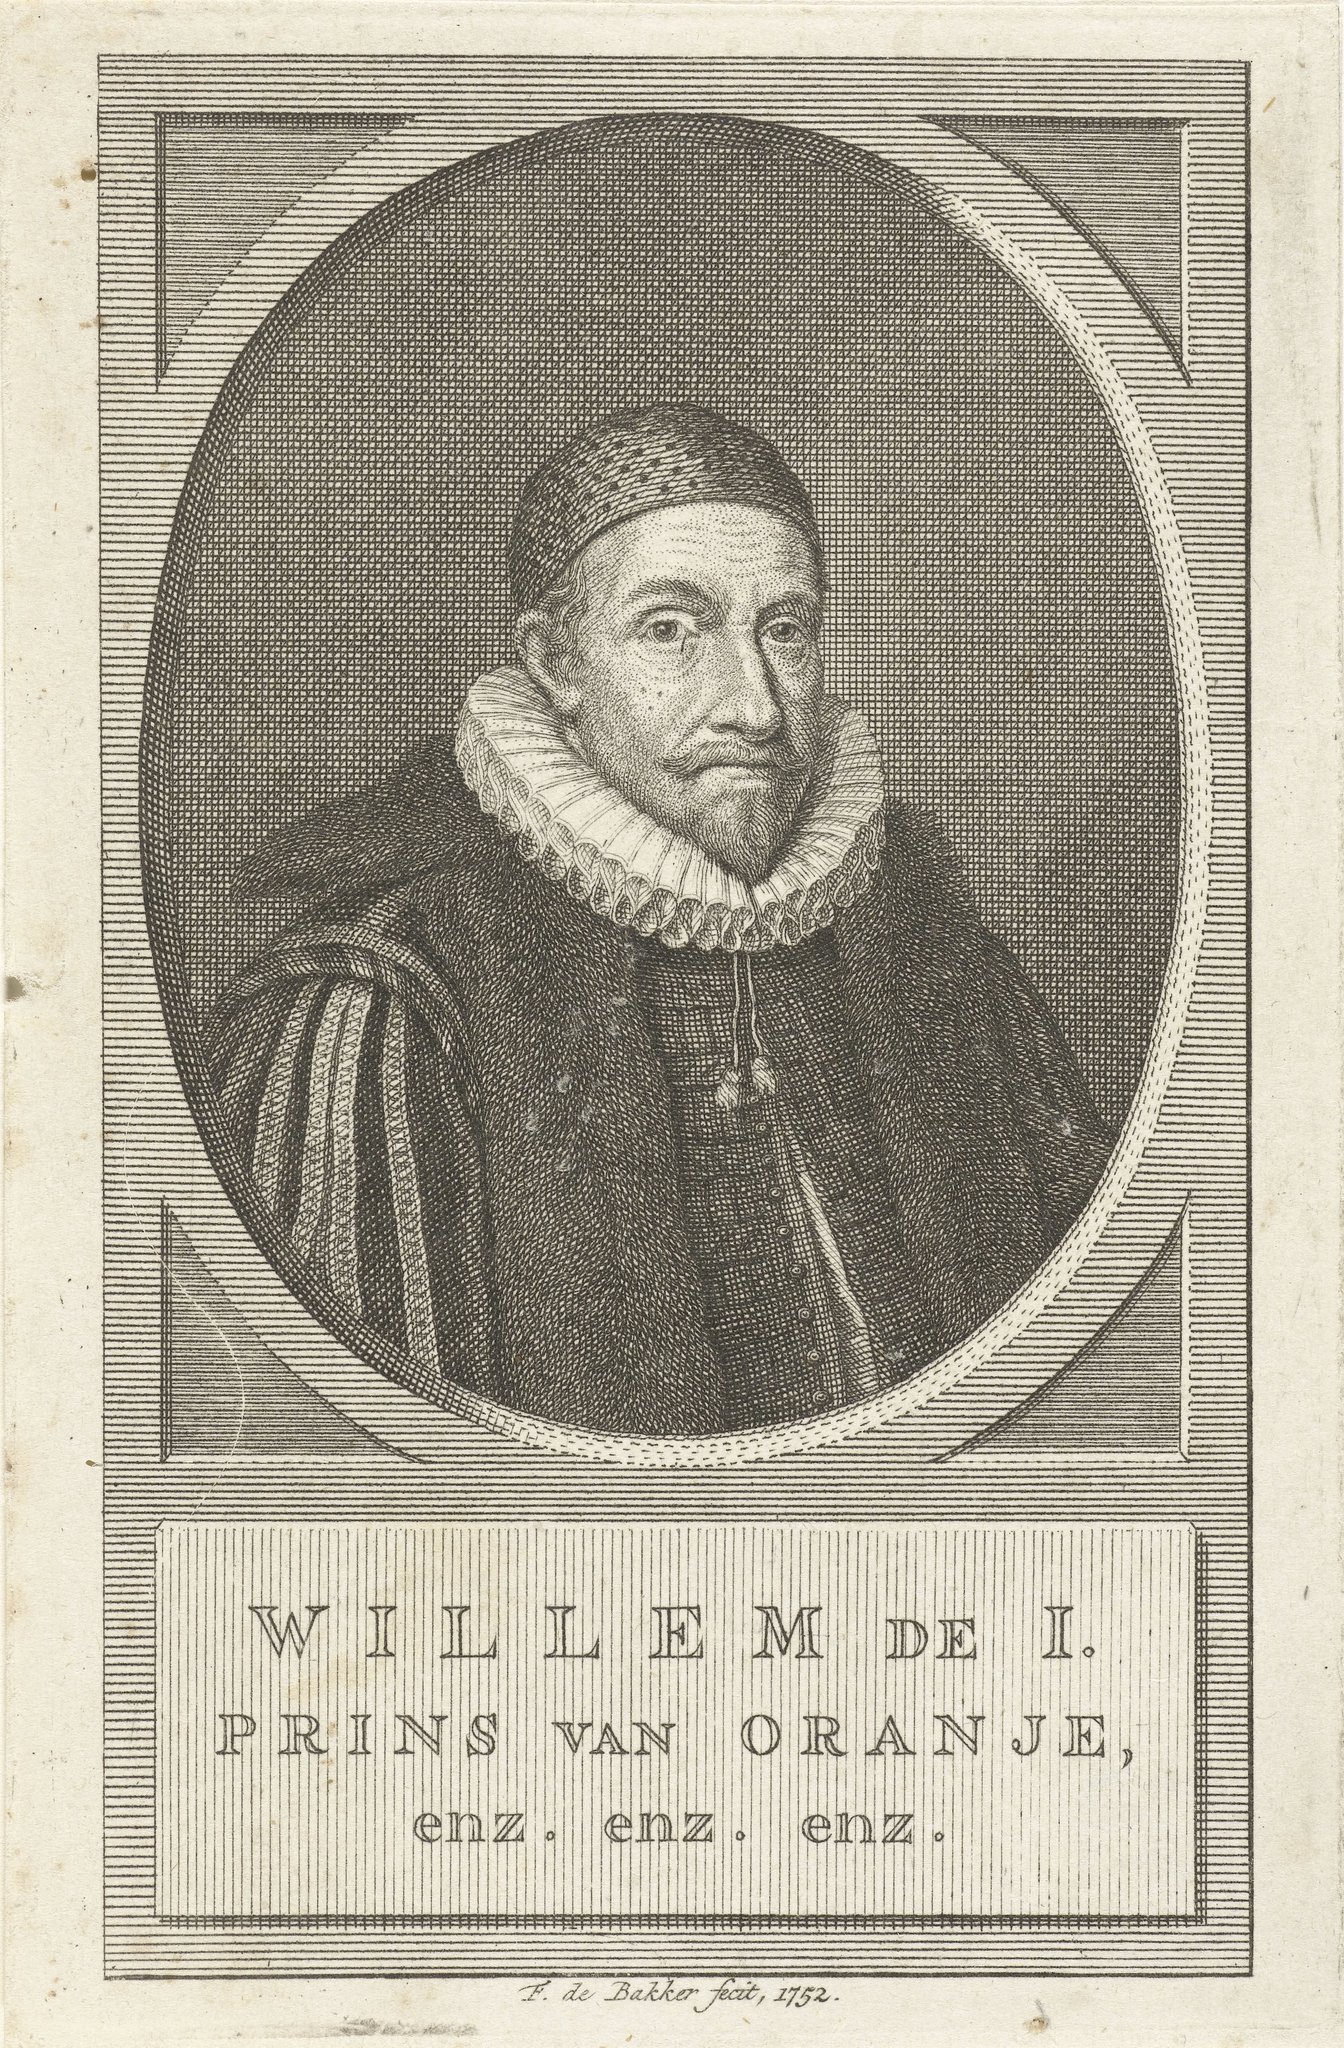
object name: print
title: Portret van Willem I, prins van Oranje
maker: frans de bakker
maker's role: print maker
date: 1752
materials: paper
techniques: etching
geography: amsterdam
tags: william i (prince of orange)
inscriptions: collector's mark: Lugt 963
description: Portret van Willem I prins van Oranje in ovaal. Onder het portret zijn naam.